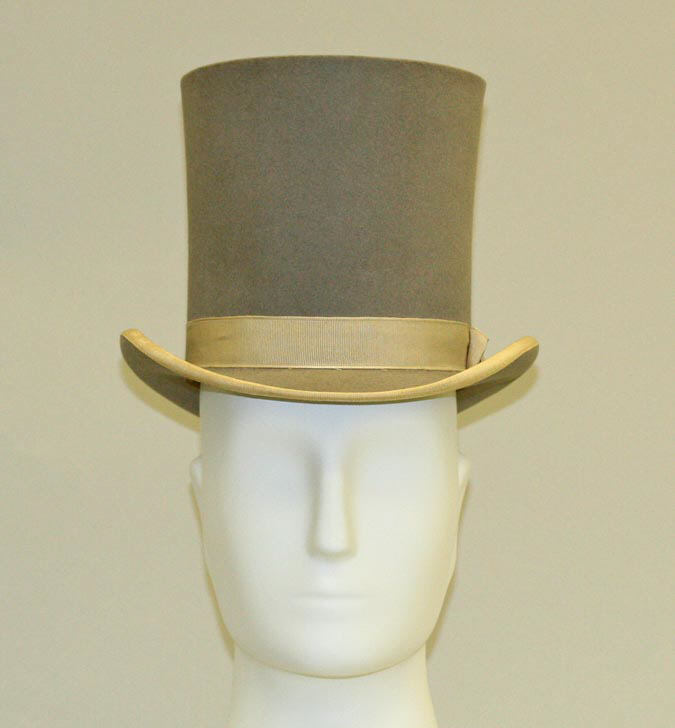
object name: top hat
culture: british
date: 1860-1869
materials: leather, paper, silk, wool